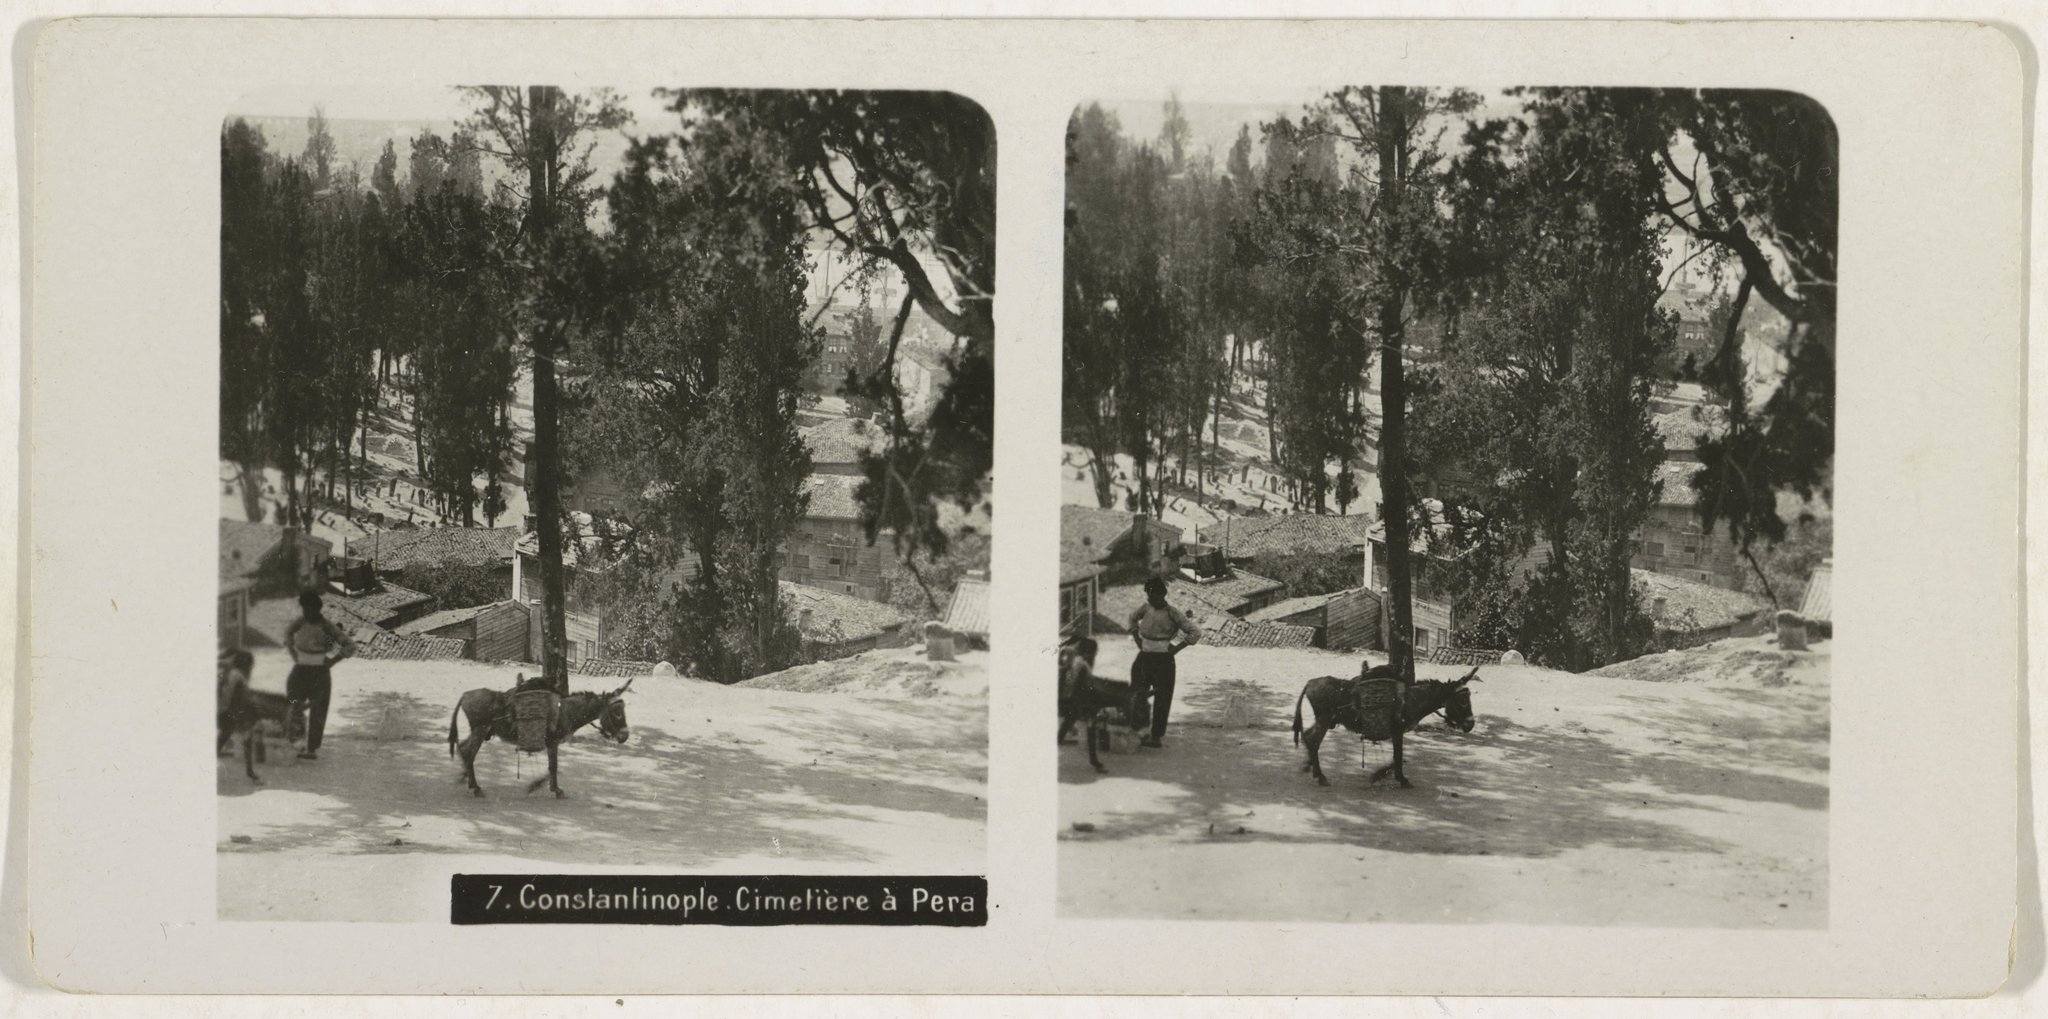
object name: stereograph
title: Gezicht op een begraafplaats te Beyoğlu, Istanboel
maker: Anonymous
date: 1903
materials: paper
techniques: gelatin silver print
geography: haarlem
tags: cemetery, park-like burying ground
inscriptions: monogram, inscription: ‘Déposée.’, number: ‘7.’, address: ‘Parklaan 49/ HAARLEM/ (Holland)’, inscription: ‘Deze stereo-foto's worden in den handel gebracht en en gros en/ en détail verkocht door de ......... (...)’